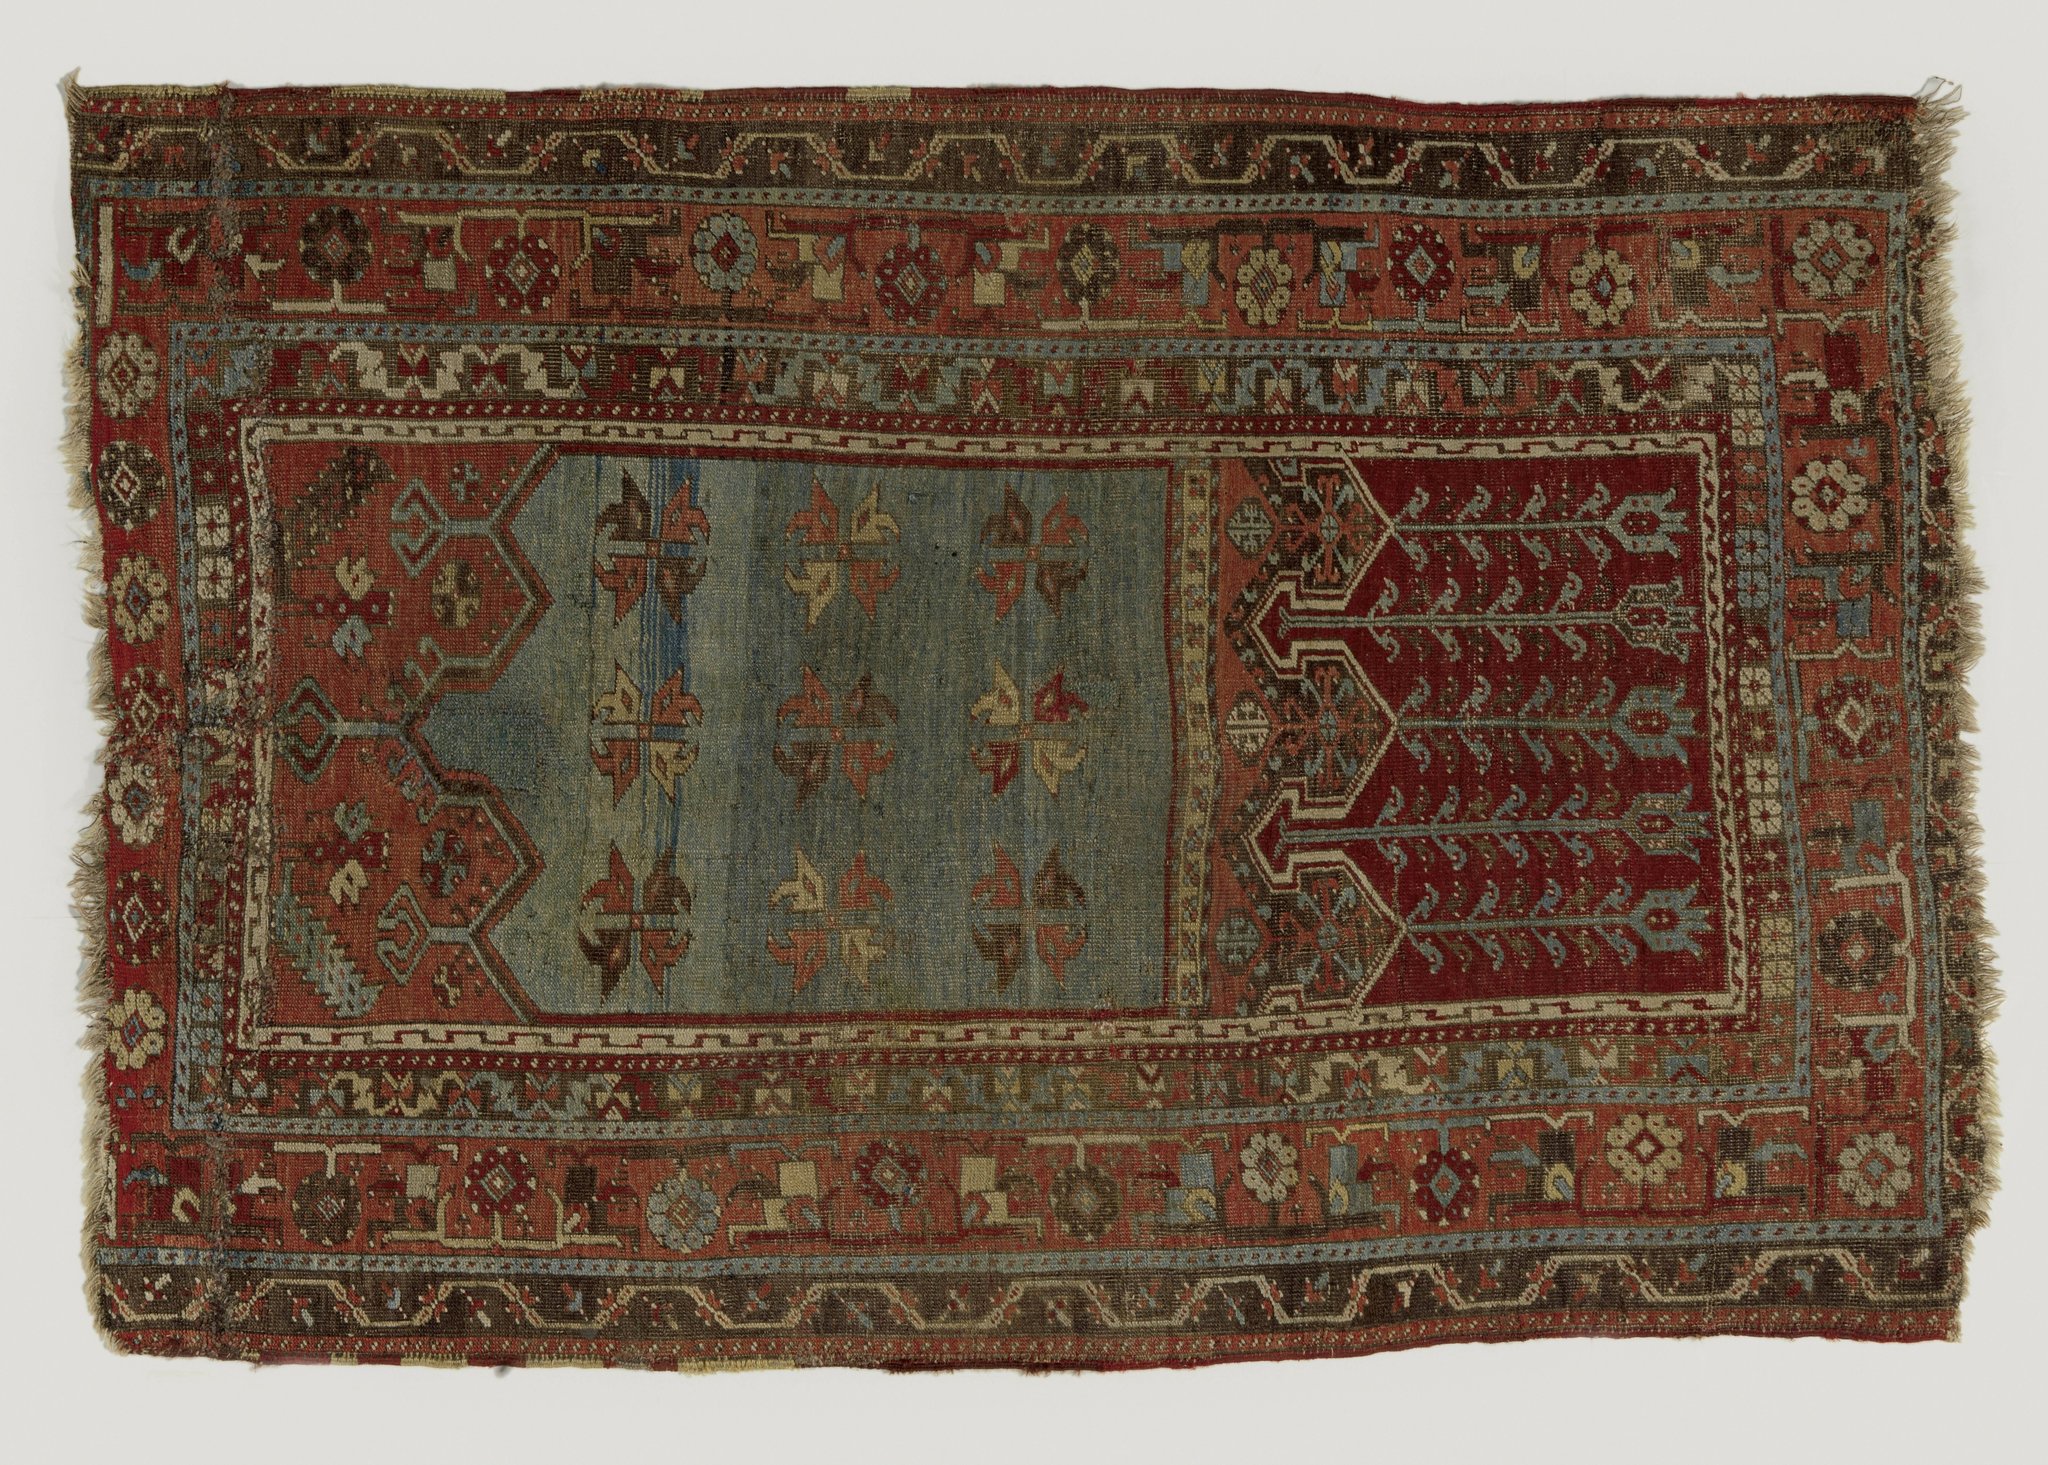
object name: tapijt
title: Bidkleed met benedendwarspaneel, LADIK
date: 1800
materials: wool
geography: ladik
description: Bidkleed met benedendwarspaneel, LADIK. Middenveld: lichtblauwe mihrab met stijve rijen van drie anjelieren en met driedelige topgevel. Lichtrode zwikken met getande lancetbladeren en sterbloemen. Onderaan een kantelenrand met witte "omegalijn", ingrijpend in groot, donkerrood dwarspaneel met hangende tulpen, afwisselend in lichtblauw (3) en zwart (2). Randen: viervoudig. De hoofdrand is lichtrood met rozetbloemen en schuine lelies aan een hoekige rank. Hij is gevat in brede zomen met hoekige ranken, de binnenste in bruin, de buitenste in bruinzwart. het gehele middenveld is in een wit lijstje gevat.